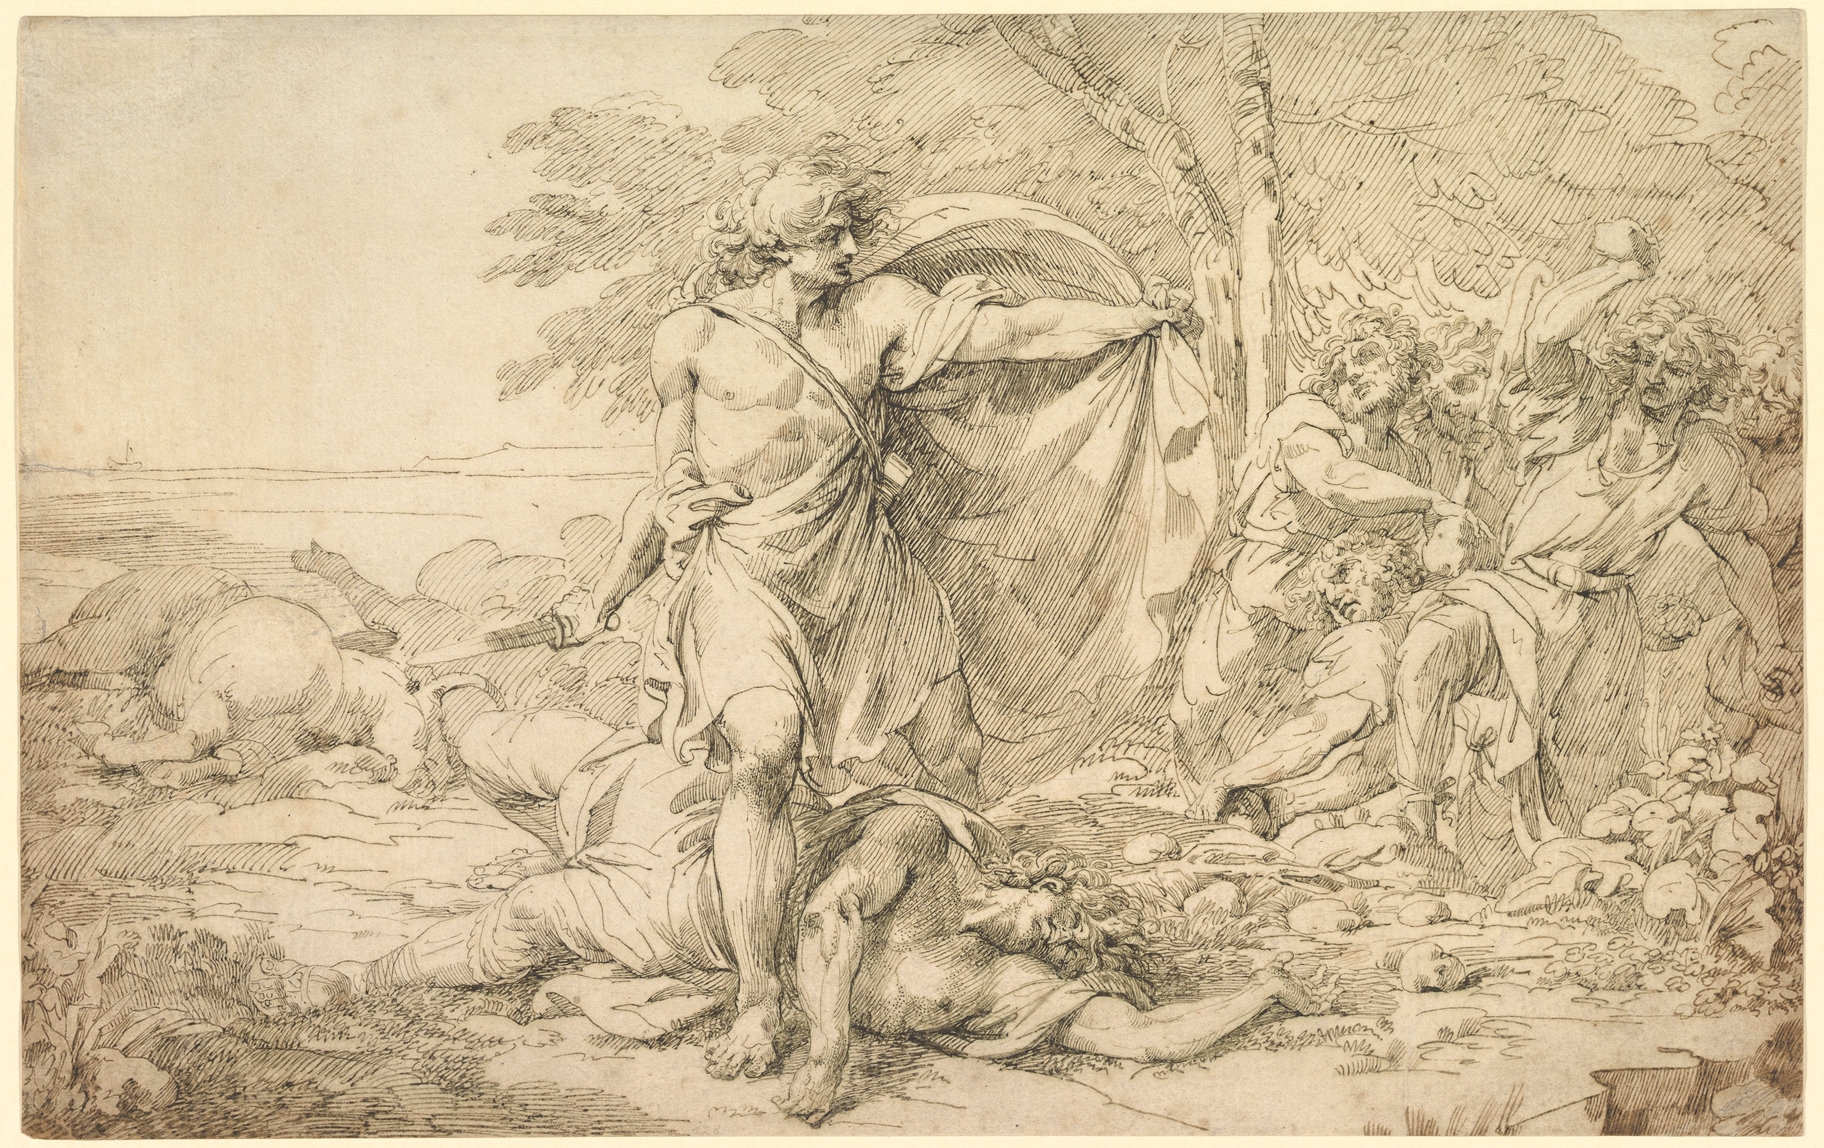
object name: drawing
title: Classical Subject of Fighting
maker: john hamilton mortimer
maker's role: artist and publisher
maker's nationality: british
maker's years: 1740-1779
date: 1760-1779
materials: chalk, ink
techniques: pen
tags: men